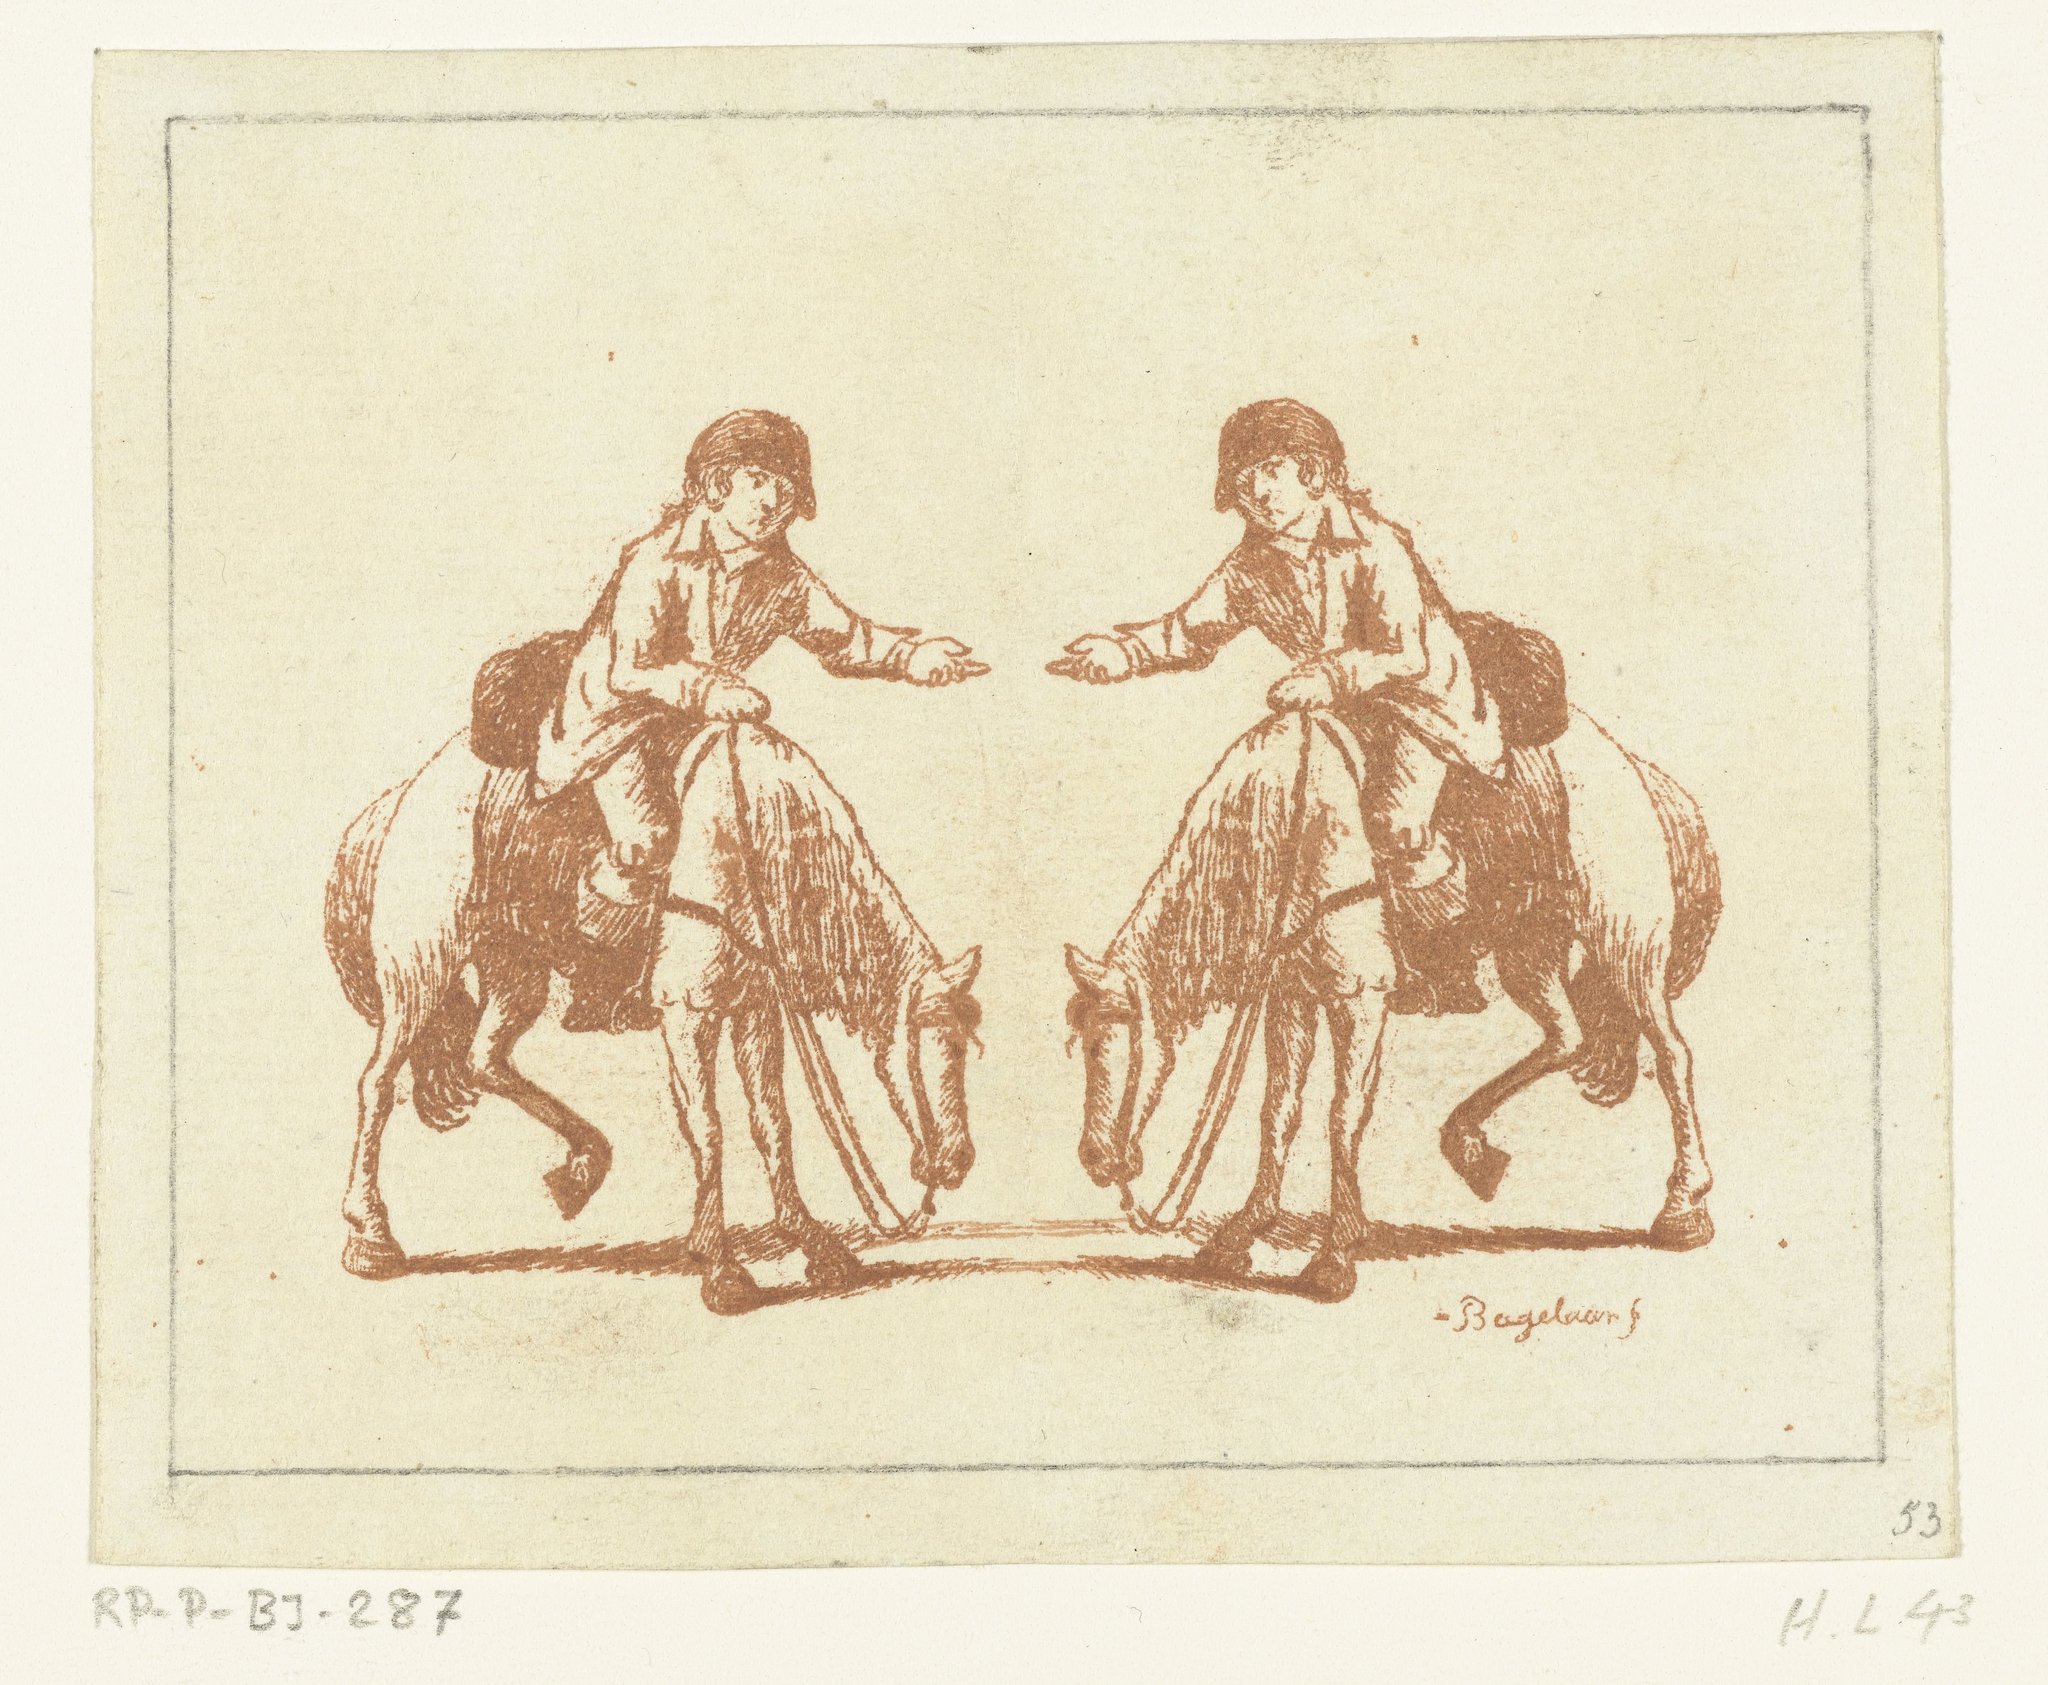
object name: print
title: Man te paard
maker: ernst willem jan bagelaar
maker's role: draughtsman, print maker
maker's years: 1775-1837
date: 1798-1837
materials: paper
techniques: printmaking, etching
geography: netherlands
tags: riding a horse, ass, or mule; rider, horseman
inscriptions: collector's mark: Lugt 2228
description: Man te paard die naar voren leunt en zijn hand uitsteekt. Met tegendruk in spiegelbeeld.